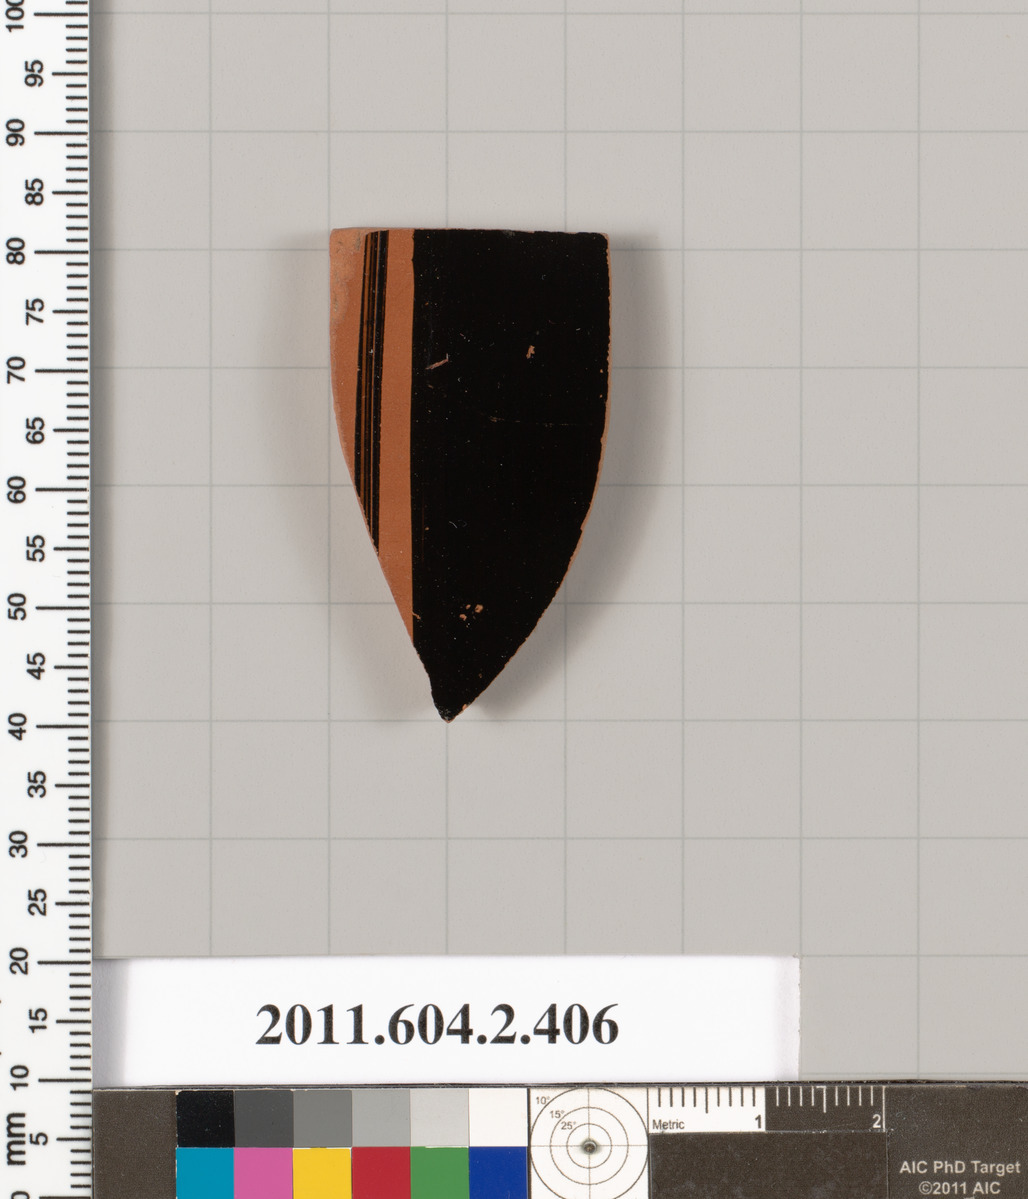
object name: column krater fragment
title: Terracotta fragment of a column-krater (bowl for mixing wine and water)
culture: greek, attic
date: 460-440 BCE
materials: terracotta